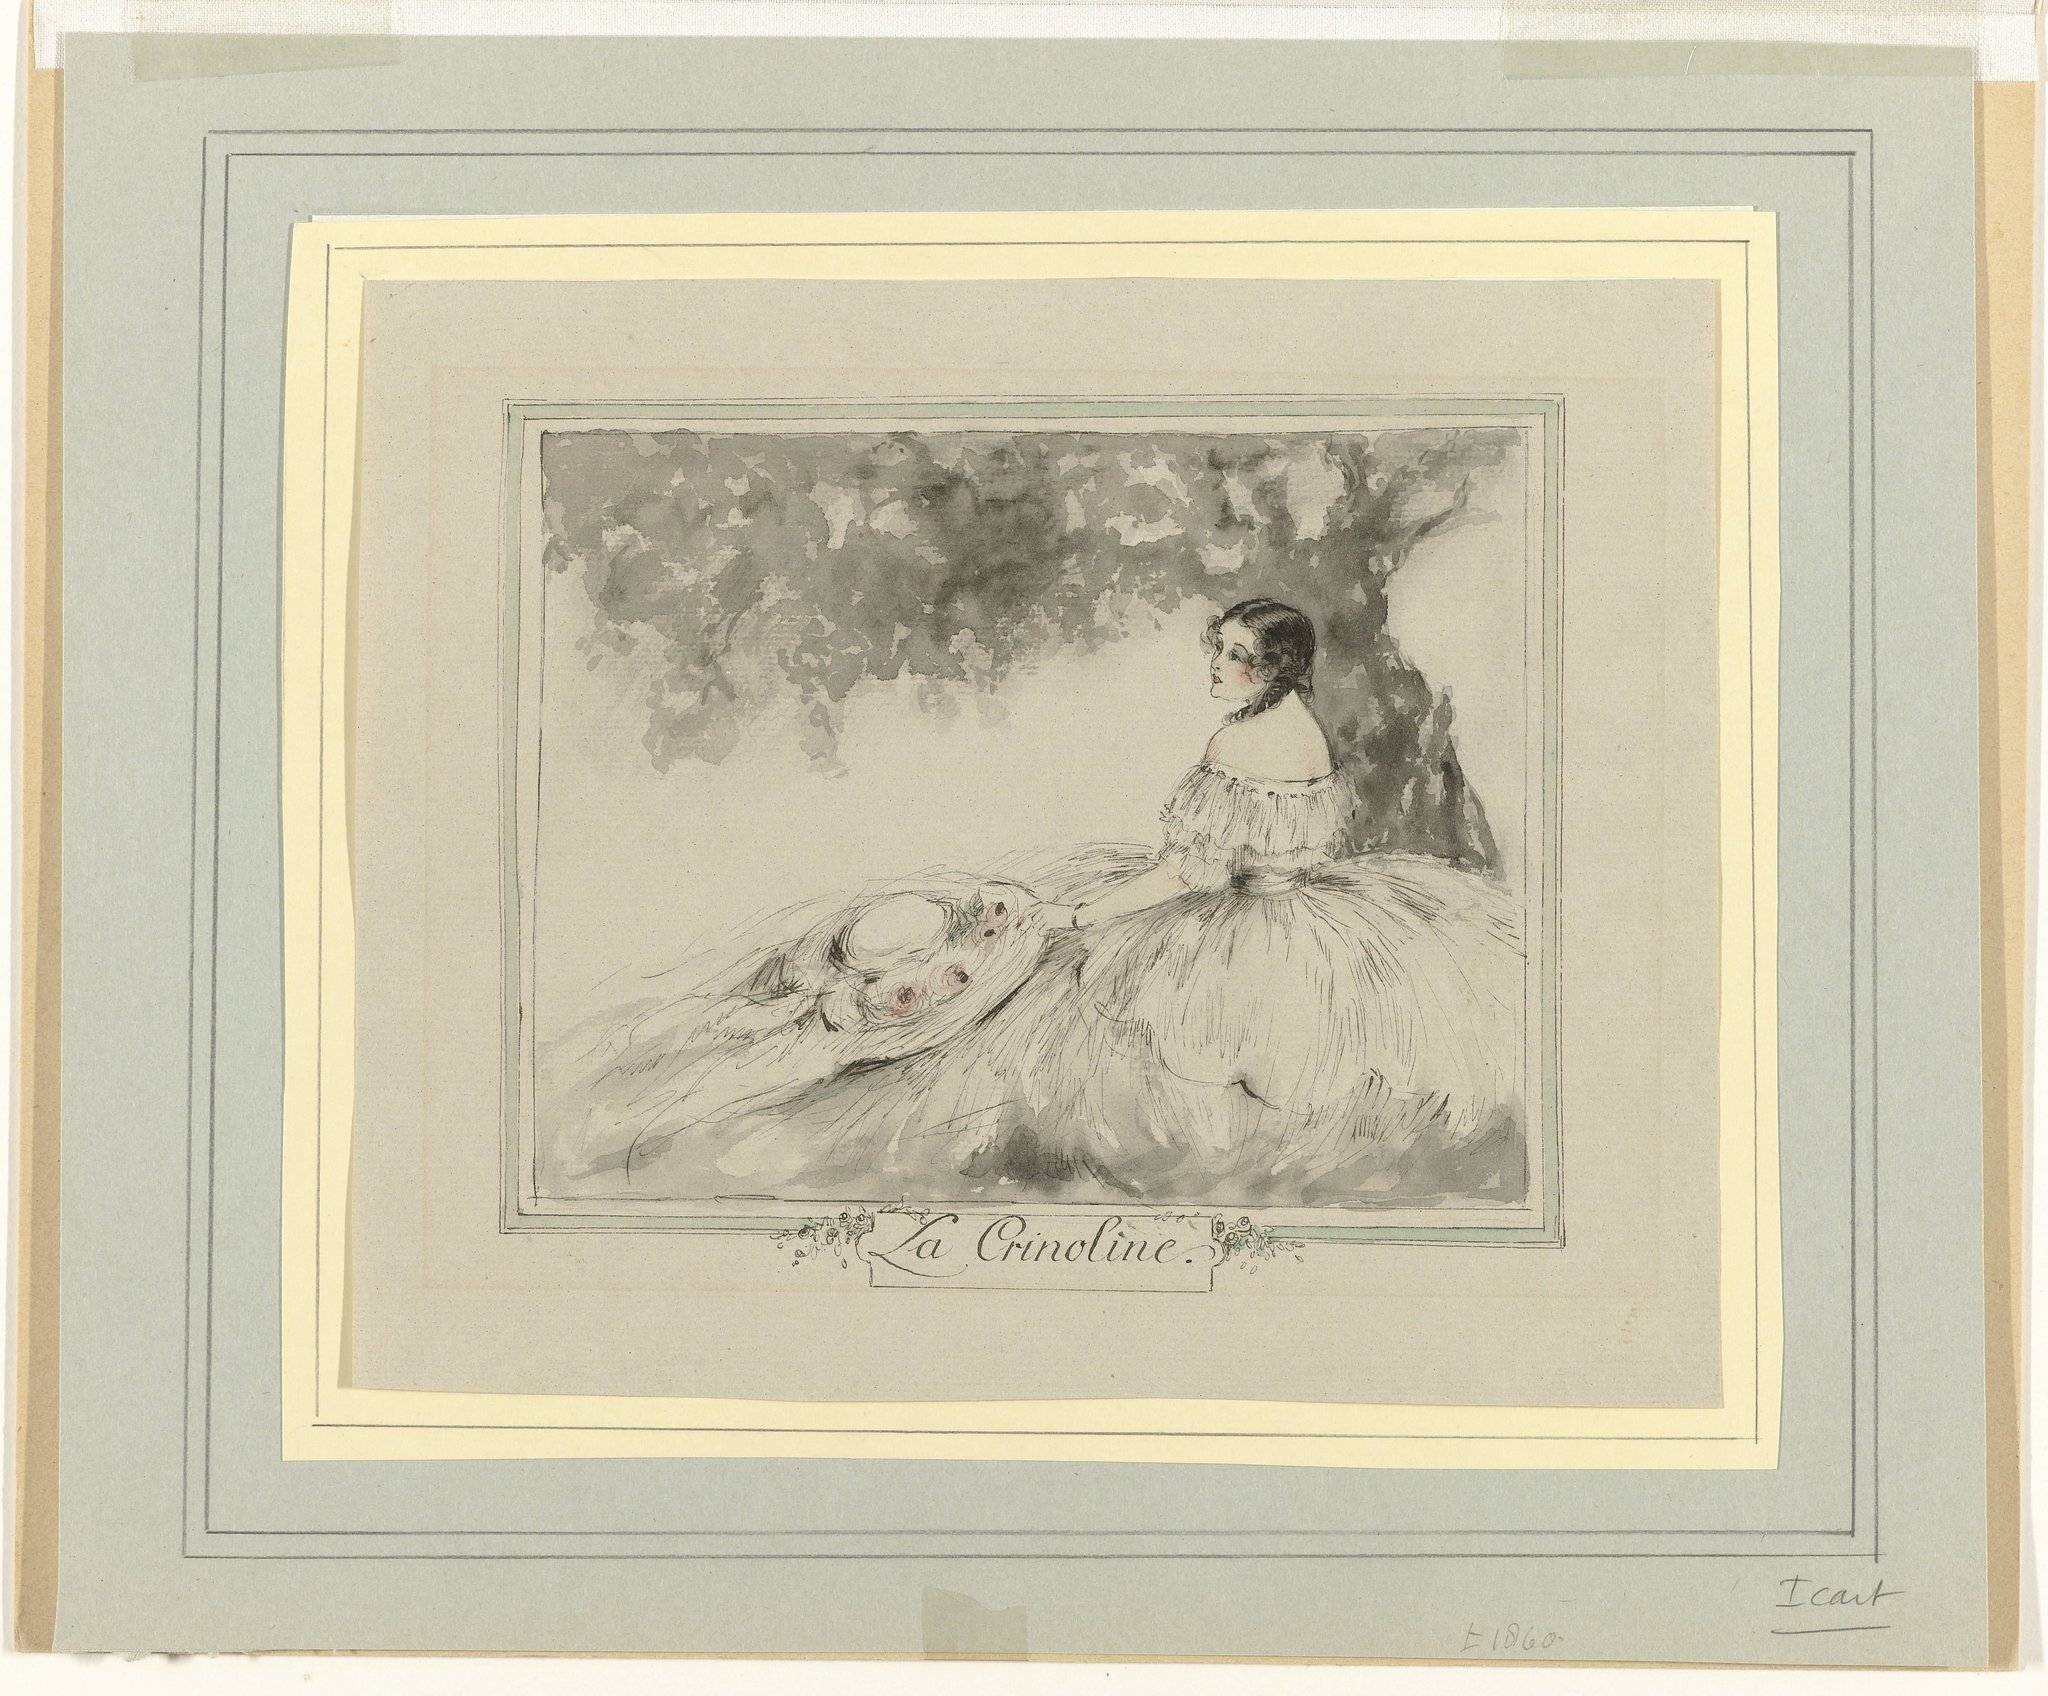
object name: watercolor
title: La Crinoline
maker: Anonymous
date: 1860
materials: ink, paper, watercolor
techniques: brush, pen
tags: fashion plates